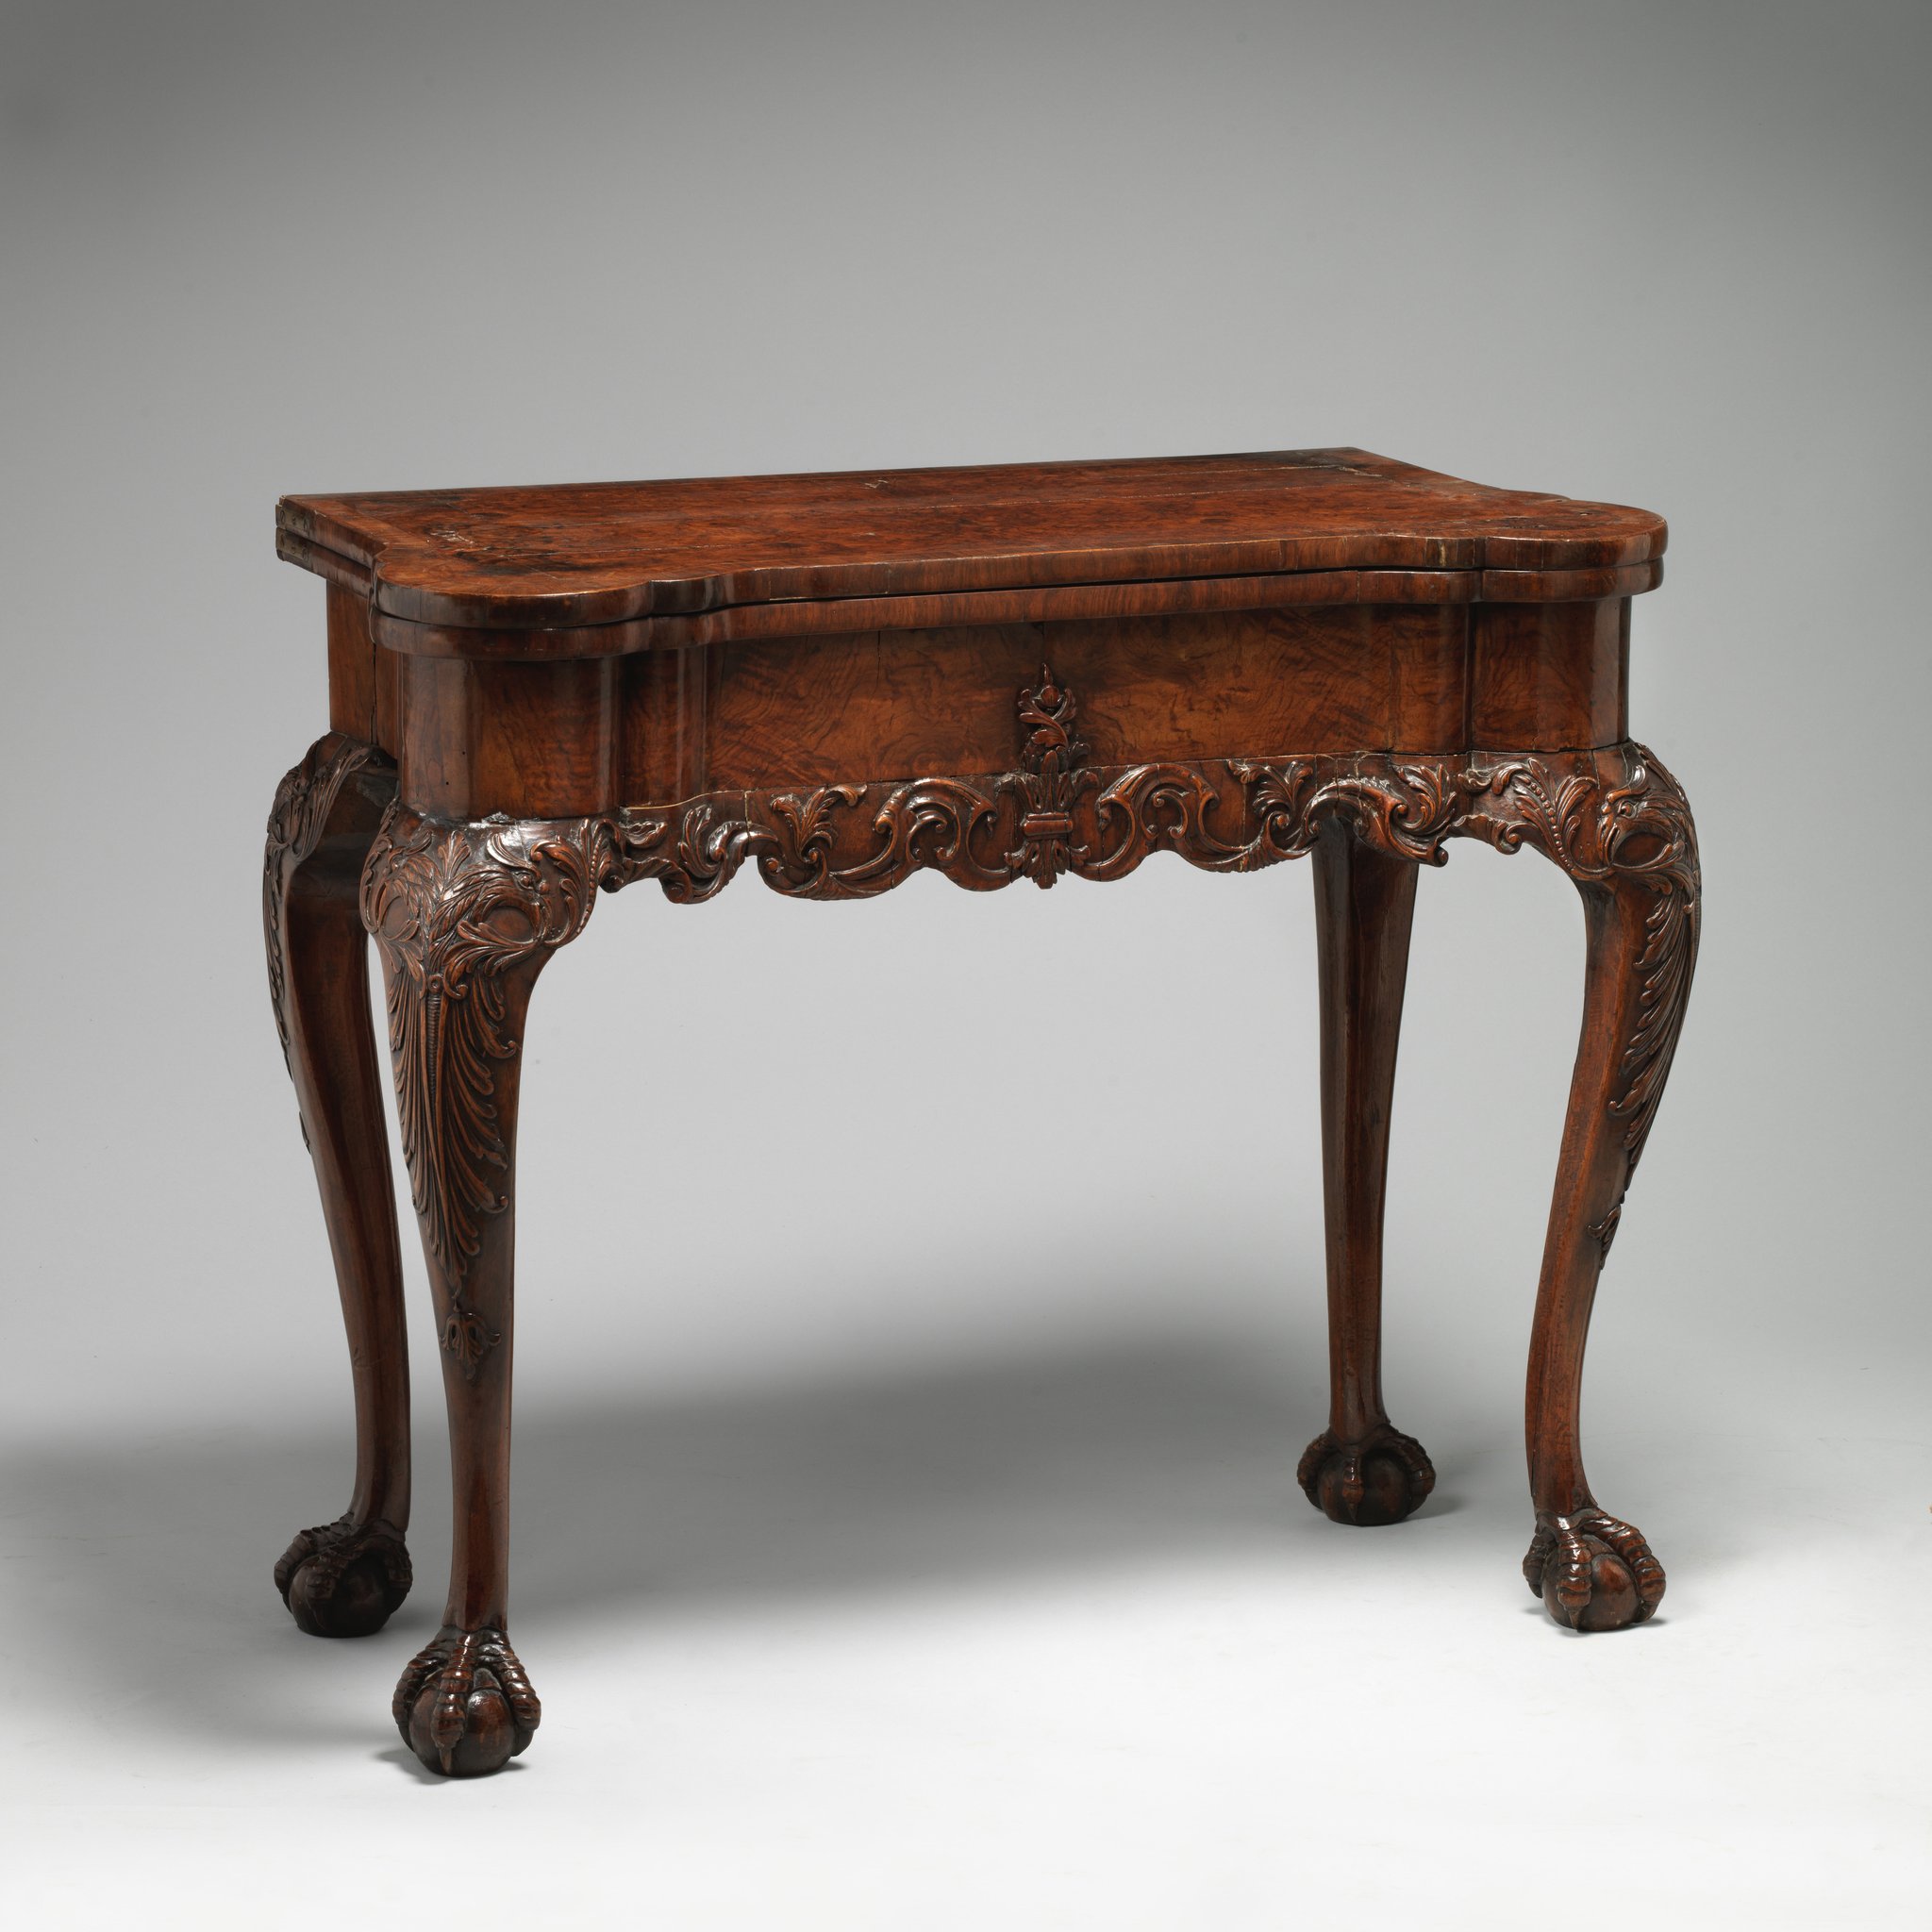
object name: card table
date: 1735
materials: wood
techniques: veneering